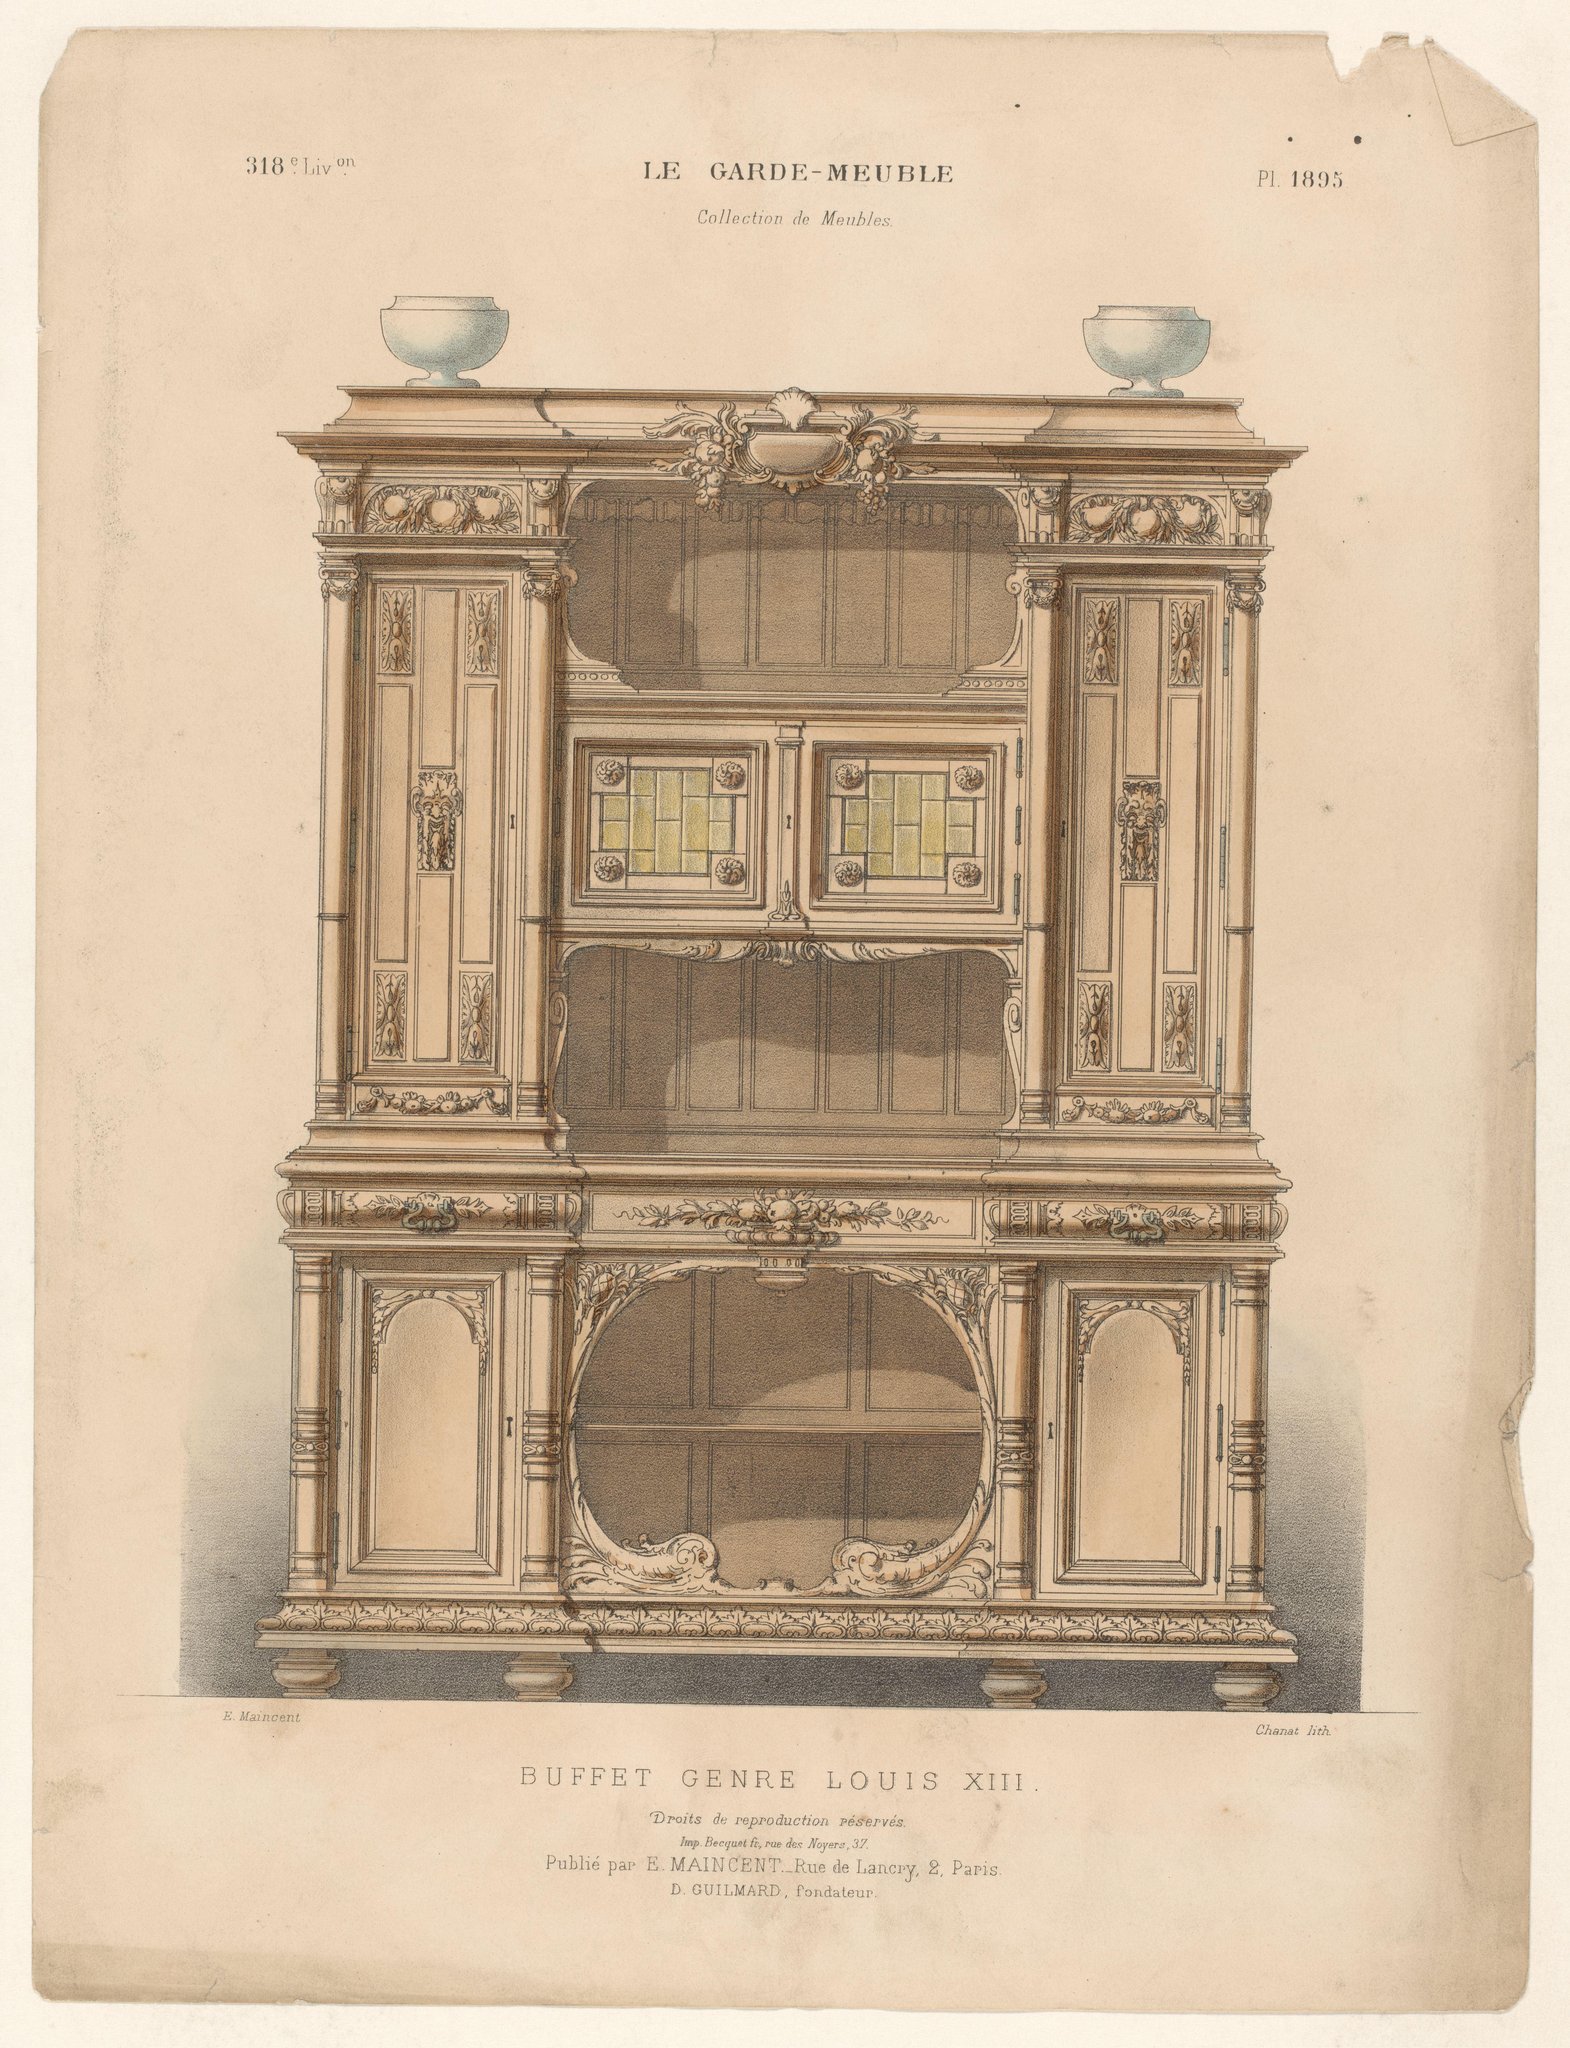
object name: print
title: Buffet genre Louis XIII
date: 1885-1895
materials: paper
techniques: hand coloring, lithograph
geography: paris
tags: furniture for storage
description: Ieder Livraison in de serie Le Garde-Meuble bevat negen platen: drie 'sièges' (zitmeubels), drie 'meubles' (diverse meubels zoals tafels en kasten) en drie 'tentures' (gordijnen en draperieën).